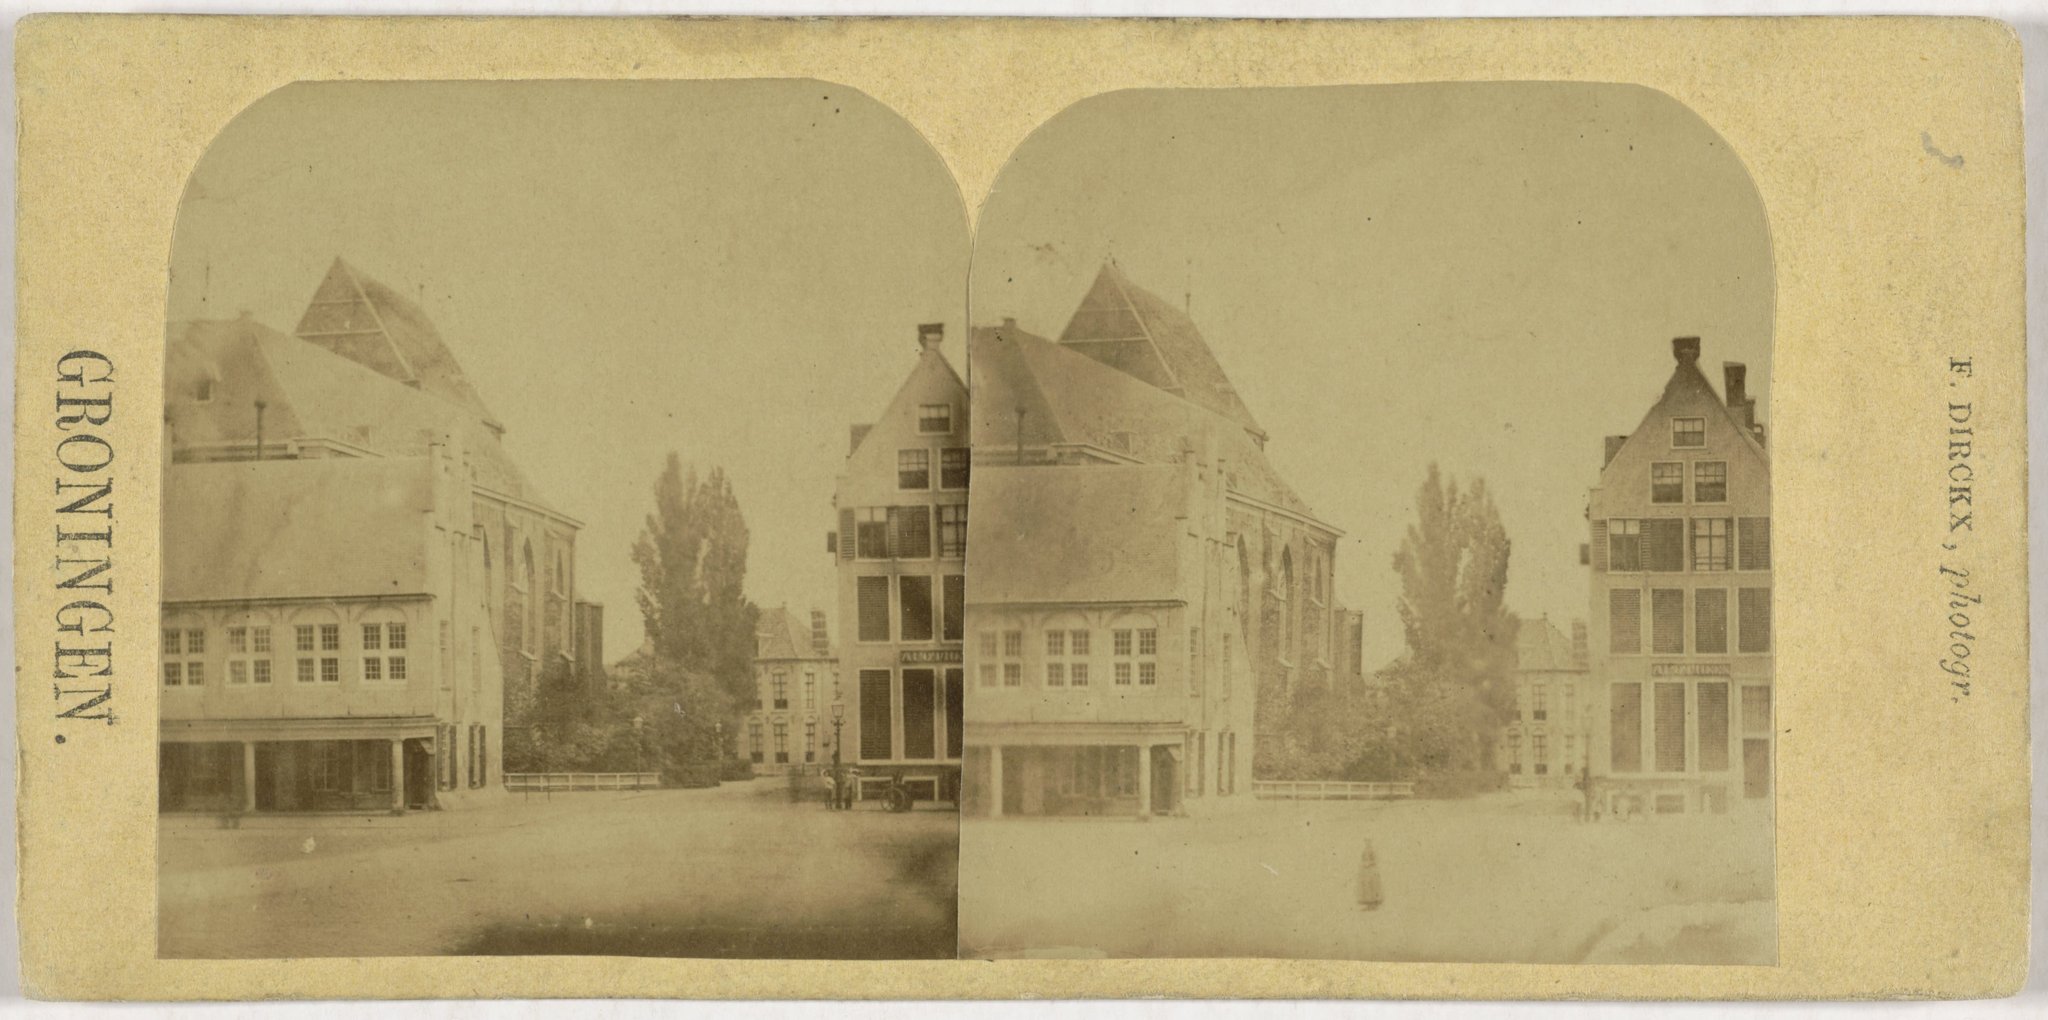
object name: stereograph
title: Gezicht op de oostzijde van de Grote Markt in Groningen met links de Hoofdwacht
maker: f. dirckx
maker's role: fotograaf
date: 1860-1876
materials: cardboard, paper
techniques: albumen print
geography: groningen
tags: square, place, circus, etc.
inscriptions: inscription: ‘Grote Markt Groningen,/ vóór 1876 (toen het torentje/ van hoofdwacht afgebroken is)/ [...]’